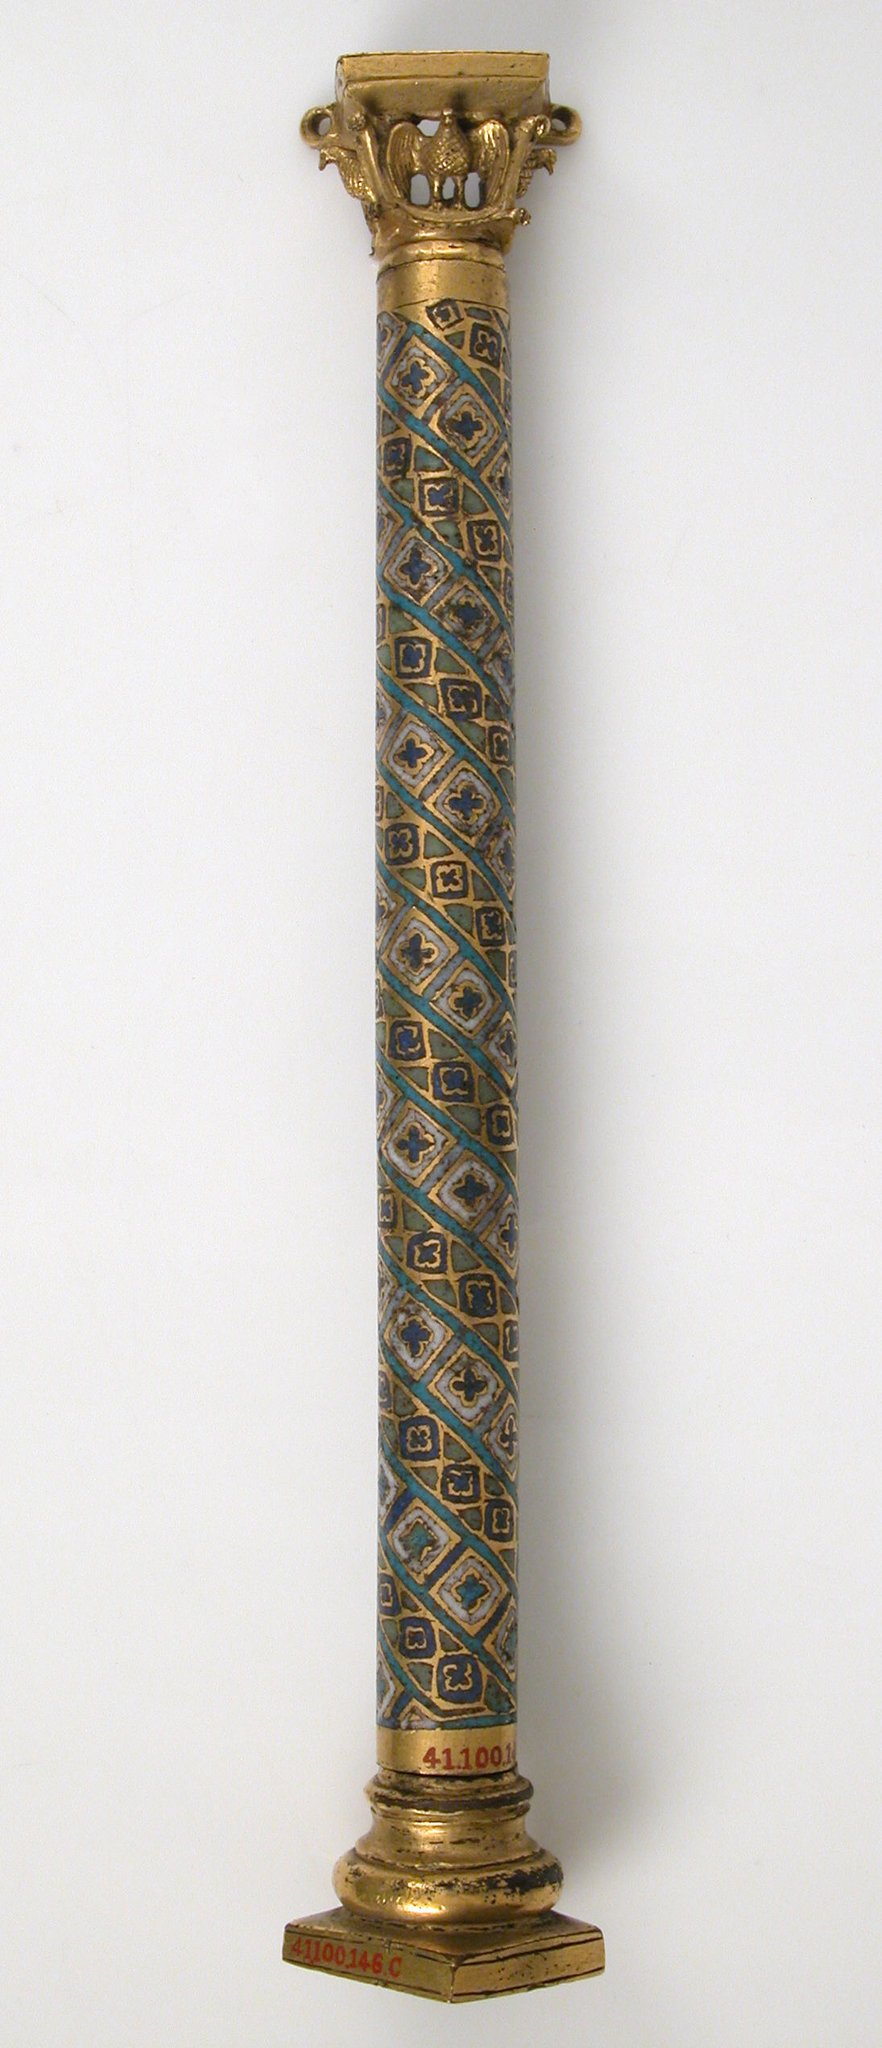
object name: colonnette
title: Colonnette from a Reliquary Shrine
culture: german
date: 1175-1200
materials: copper alloy, enamel, gilt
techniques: enamel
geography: germany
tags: eagles,reliquaries